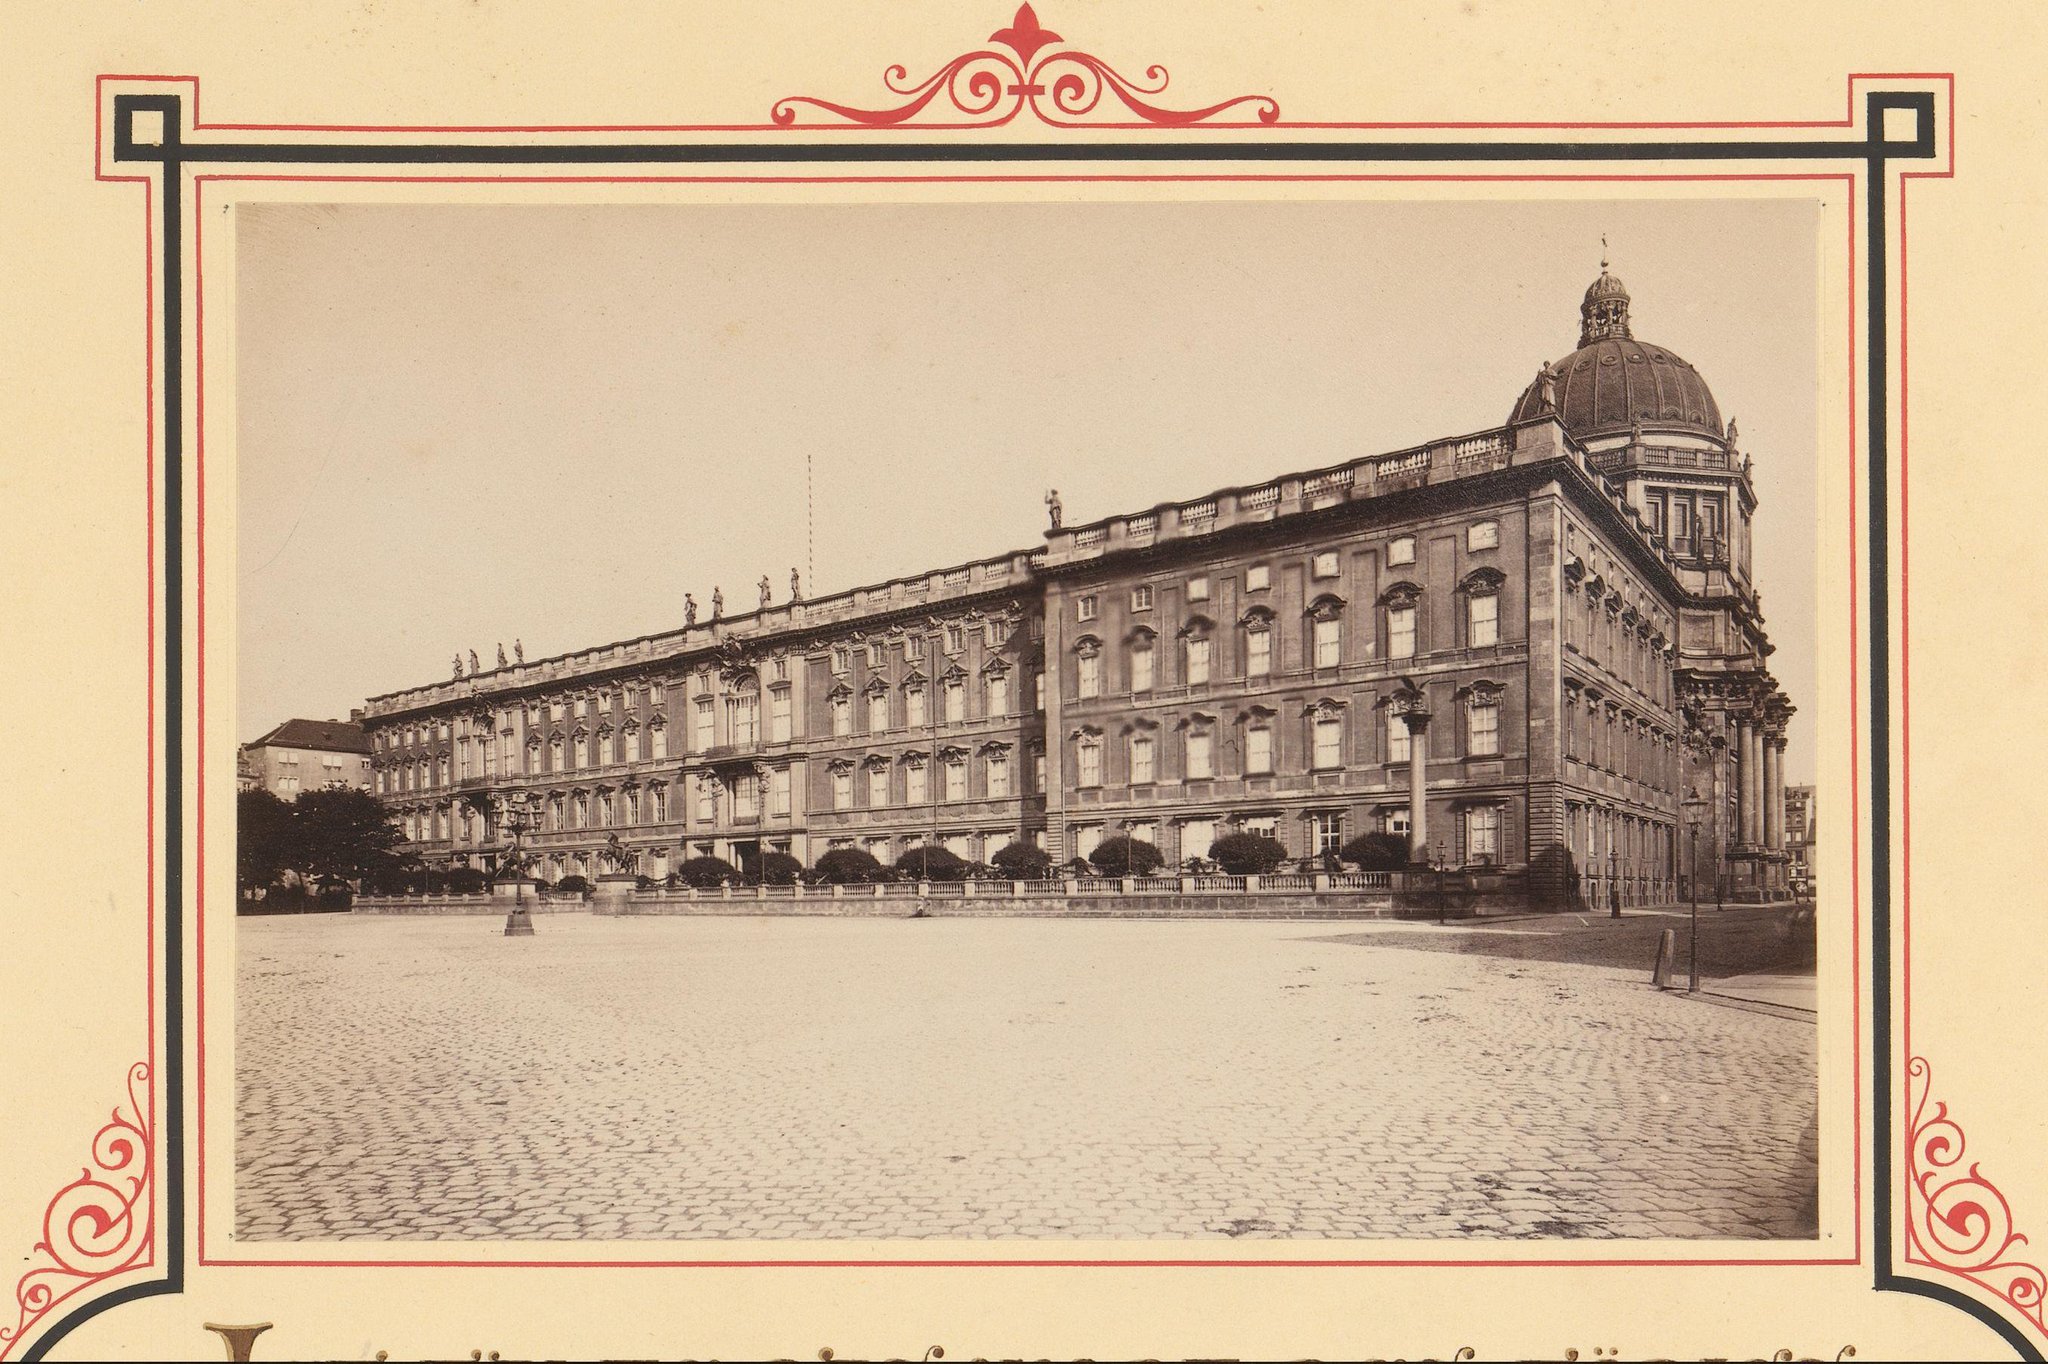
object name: photograph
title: Exterieur van het Berliner Stadtschloss, Berlijn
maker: Anonymous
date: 1873-1875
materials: paper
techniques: albumen print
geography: berlin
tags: palace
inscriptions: inscription: ‘Ich halte das Wort des Königs/ und den Eid Gottes. Spr.Sal. 8.2.’